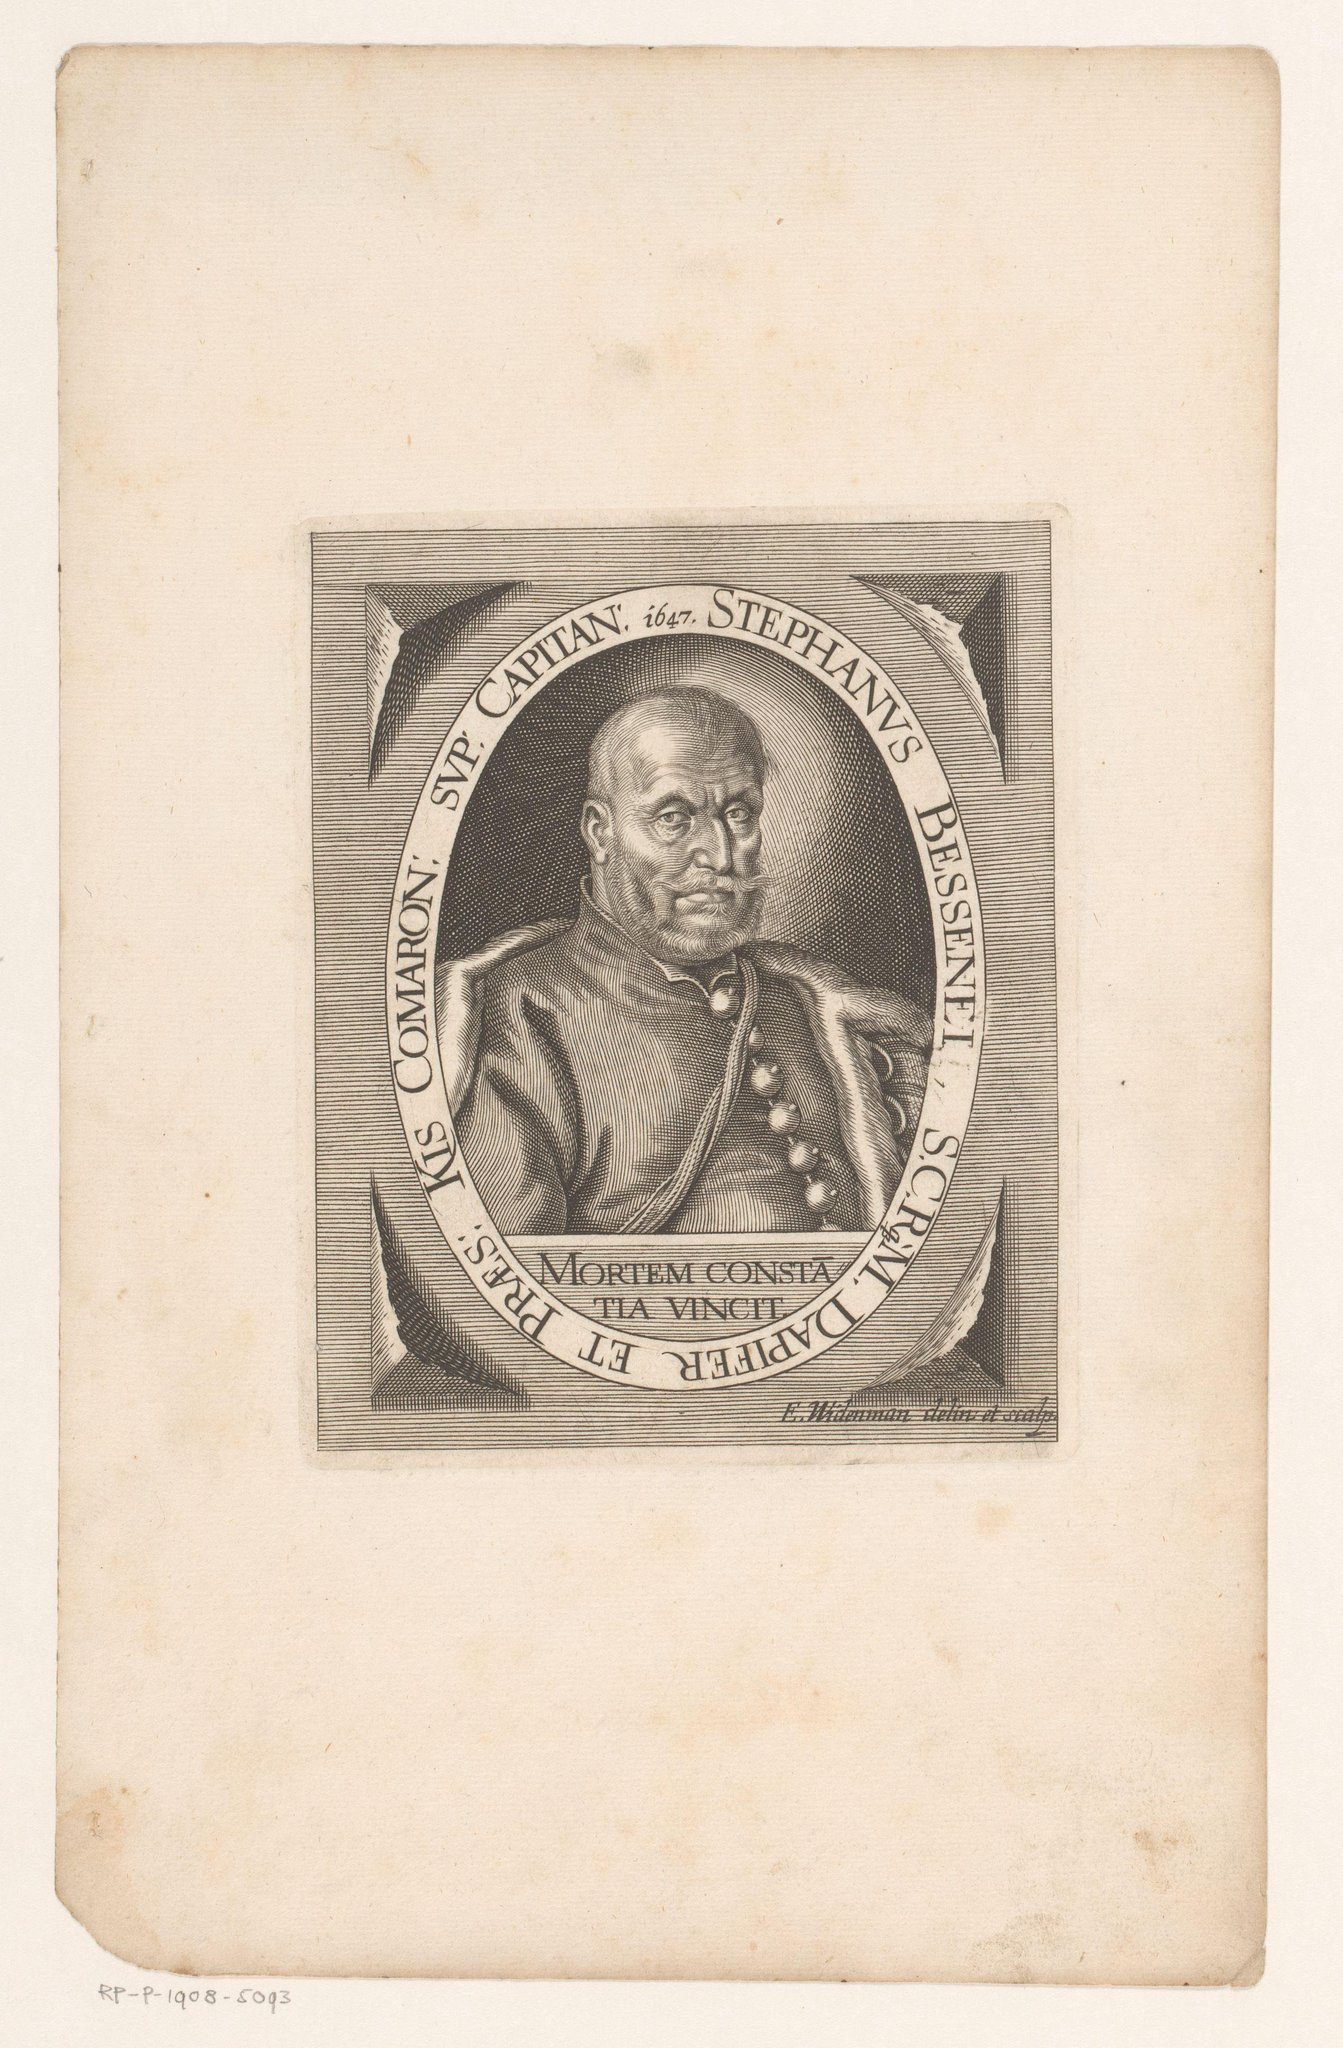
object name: print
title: Portret van Stephan Bessenei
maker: elias widemann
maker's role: print maker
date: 1647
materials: paper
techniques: engraving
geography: vienna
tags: historical persons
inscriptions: collector's mark: Lugt 2228